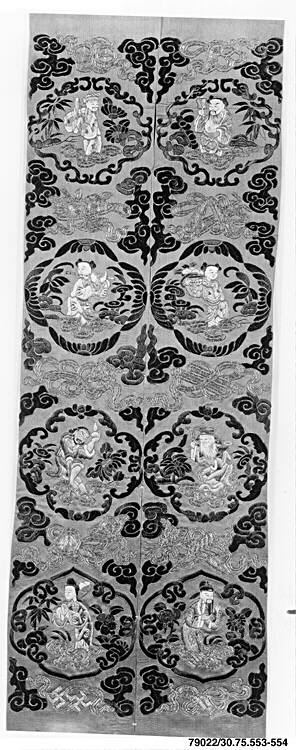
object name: sleeve band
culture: chinese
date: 1801-1900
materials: metal thread, silk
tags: men